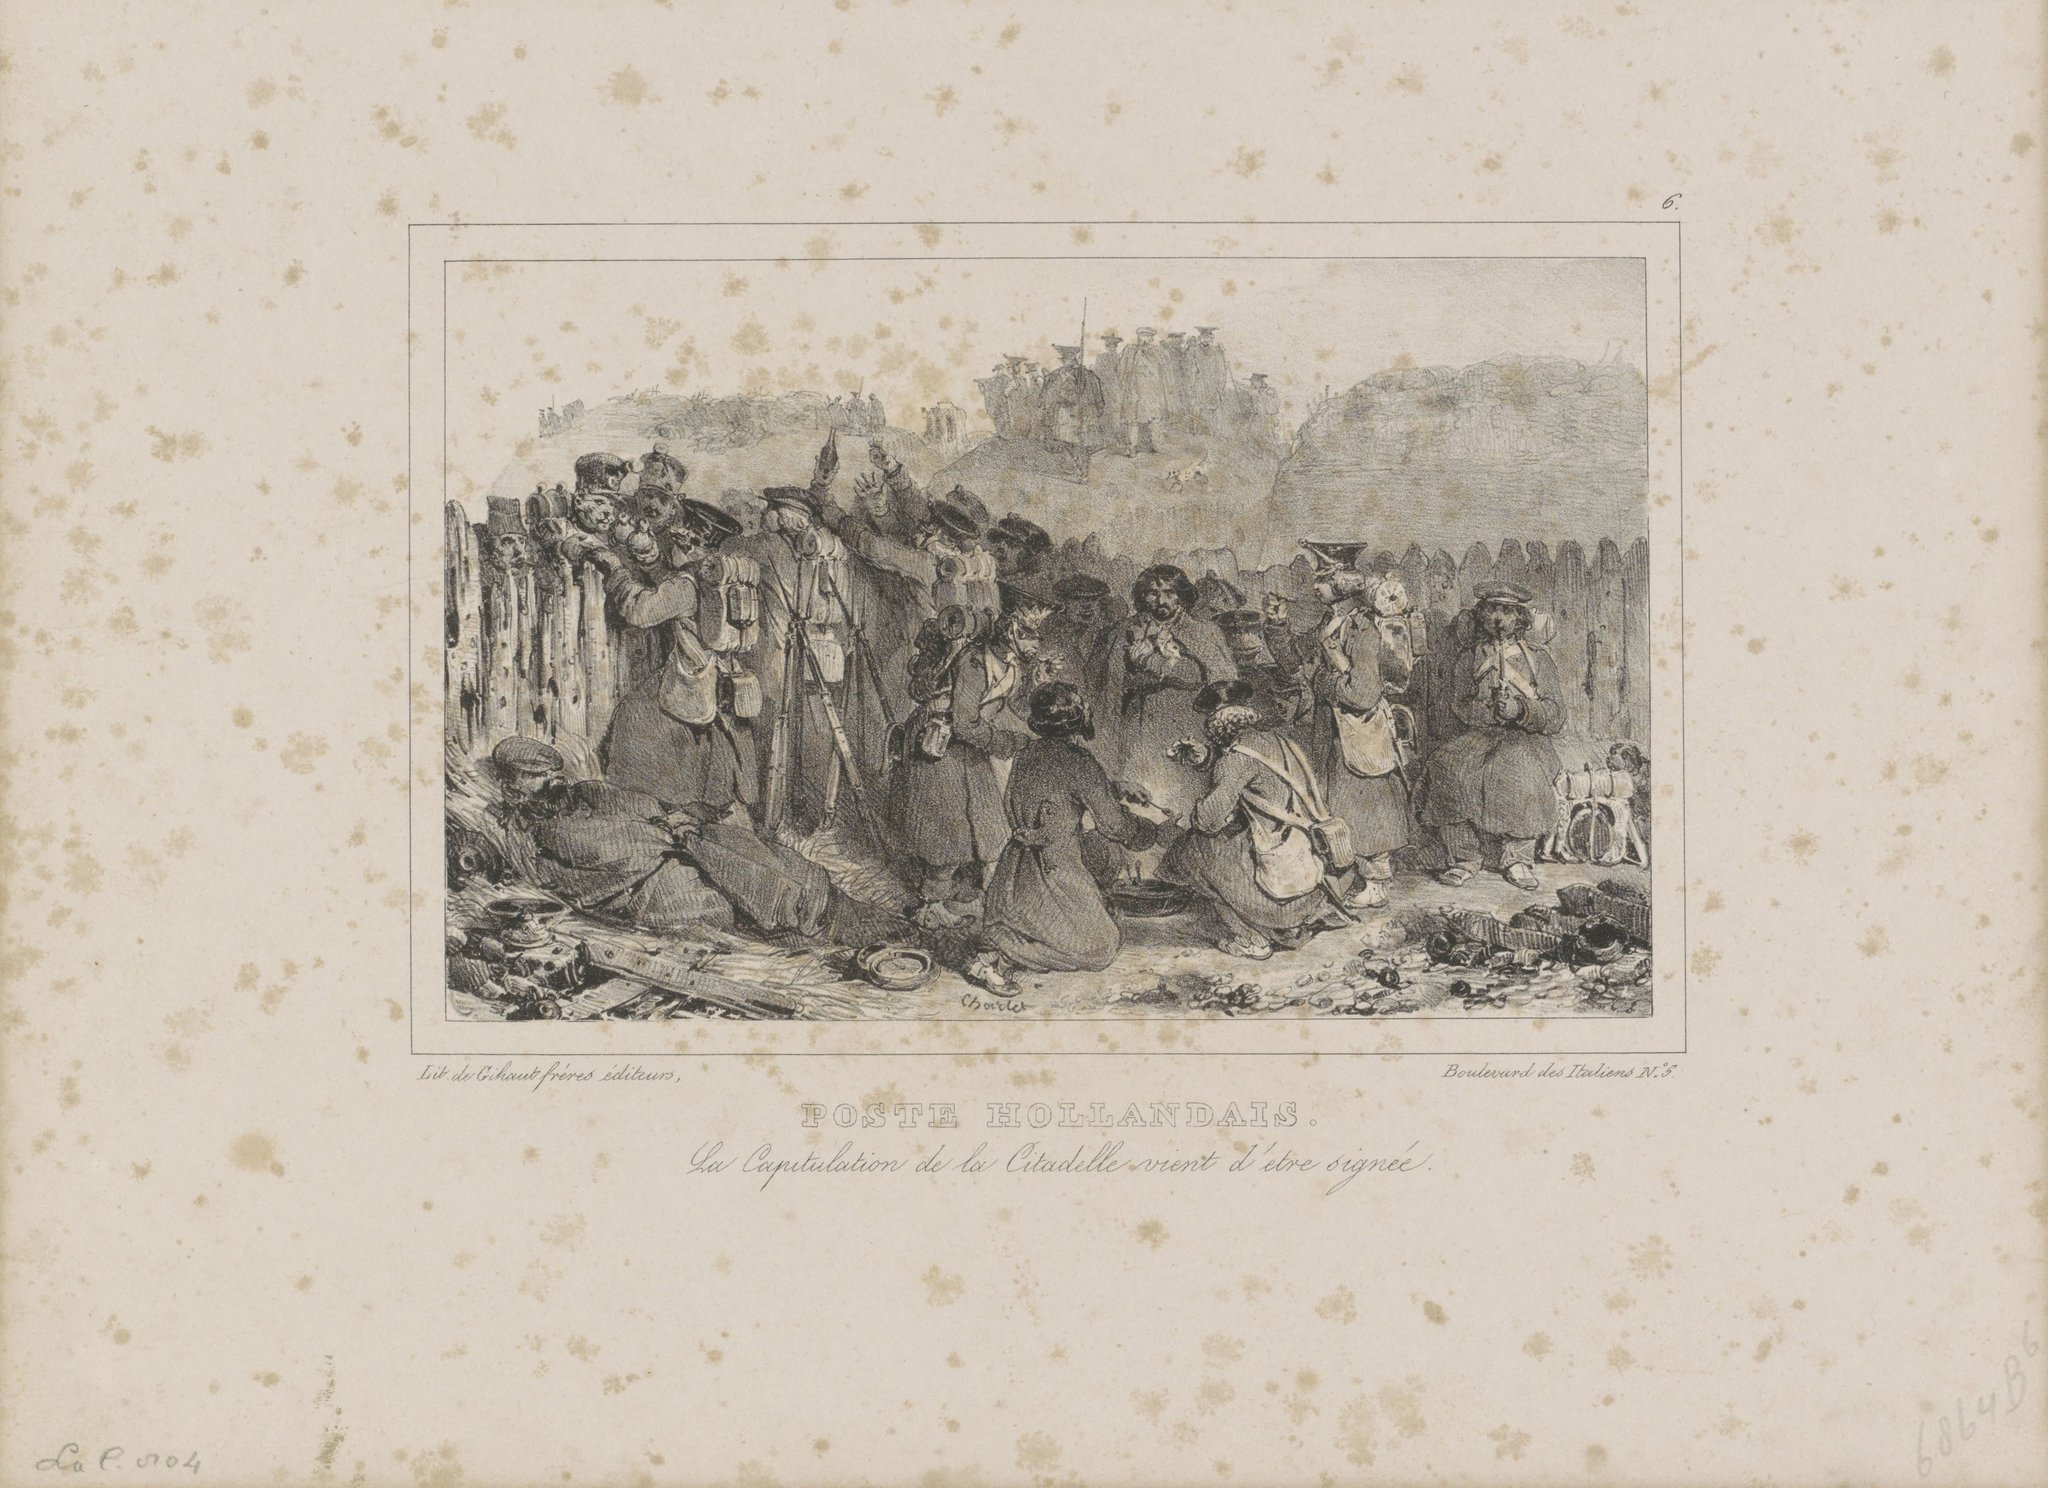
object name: print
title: Poste Hollandaise. La Capitulation de la Citadelle vient d'etre signée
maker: nicolas toussaint charlet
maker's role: draughtsman, painter, print maker, printer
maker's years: 1792-1845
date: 1832-1833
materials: paper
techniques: lithograph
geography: paris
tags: defence of fortification or city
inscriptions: collector's mark: Lugt 2228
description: Een Nederlandse stelling met soldaten in de door de Fransen belegerde Citadel van Antwerpen, november-december 1832. Links delen Nederlandse en Franse soldaten kruiken met drinken. Onderdeel van een serie van twintig bladen uit 1833 met voorstellingen van de militaire interventie van het Franse Noordelijke Leger in België in 1832.